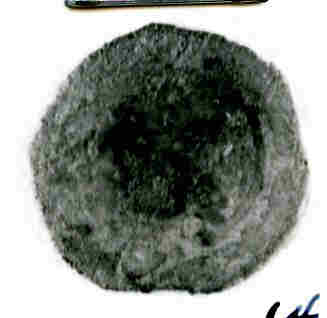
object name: coin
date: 701-800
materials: copper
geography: iran